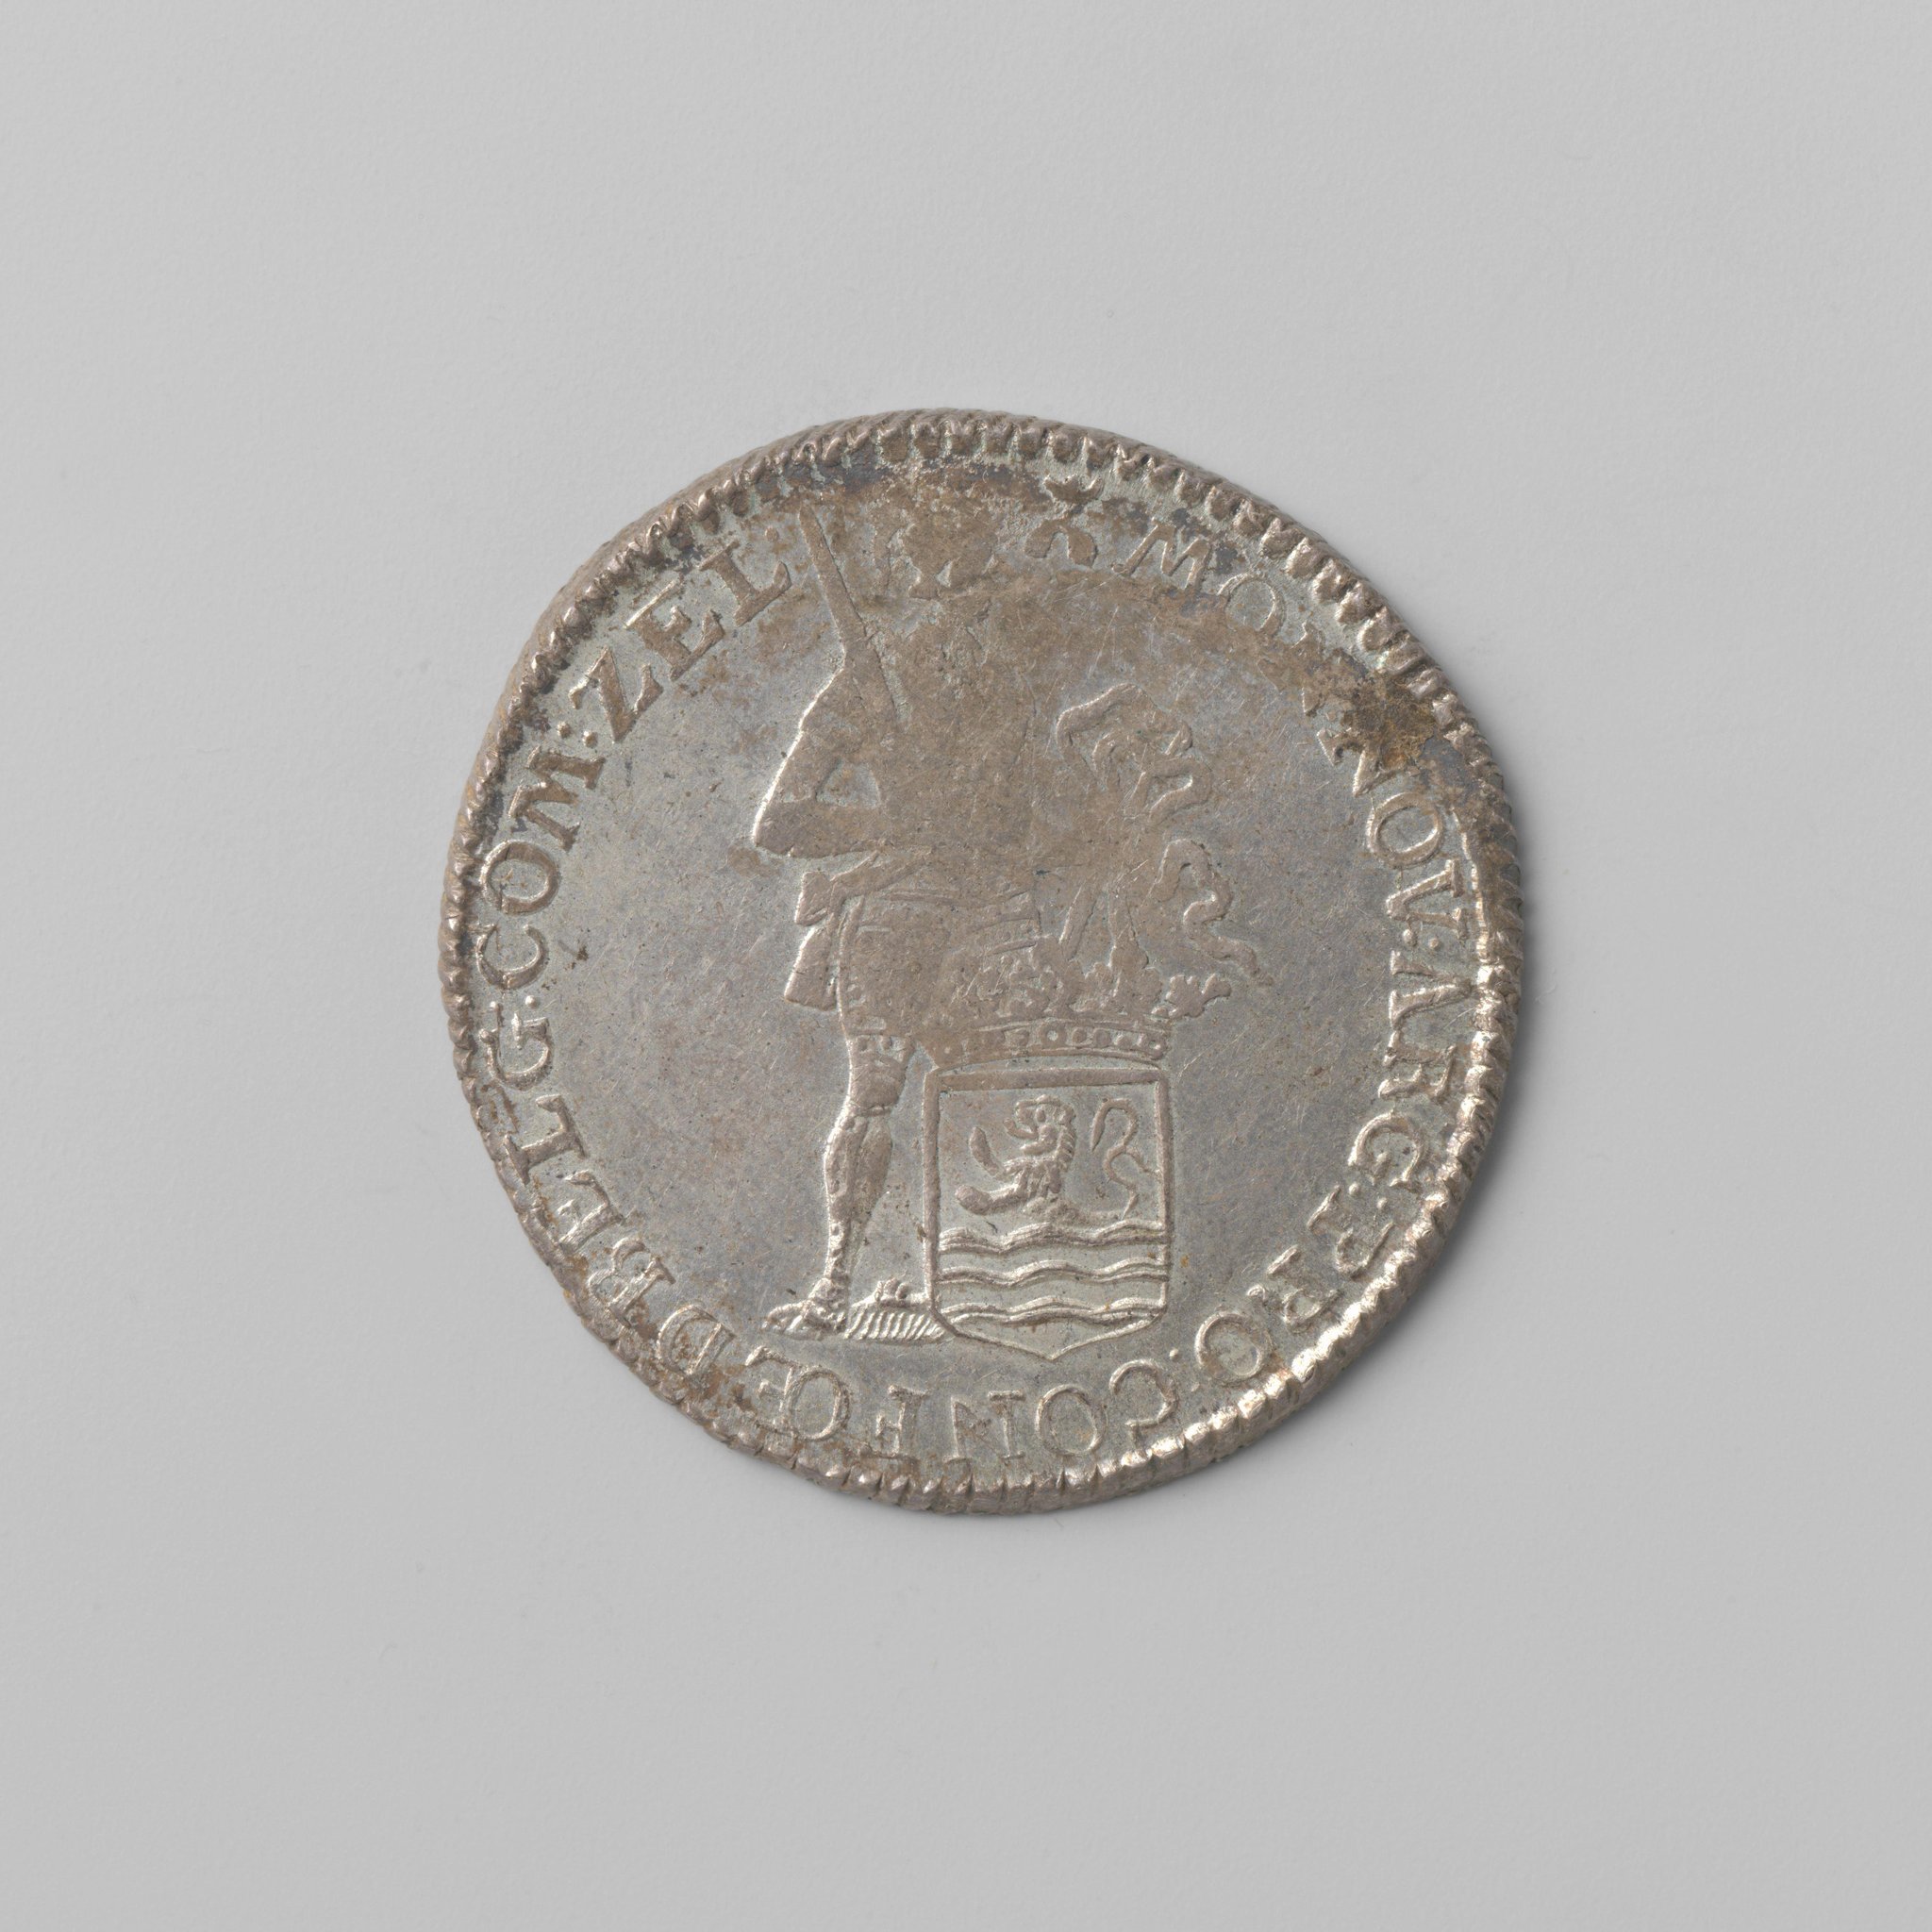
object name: zilveren dukaat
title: Zeeuwse kwart zilveren dukaat, 1780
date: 1780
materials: silver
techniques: striking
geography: middelburg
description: Zilveren munt. Voorzijde: staande geharnaste ridder naar rechts met zwaard in rechterhand en gekroond wapenschild van Zeeland aan lint in linkerhand. Keerzijde: versierd gekroond generaliteitswapenschild. Boven kroon jaartal. Kabelrand.